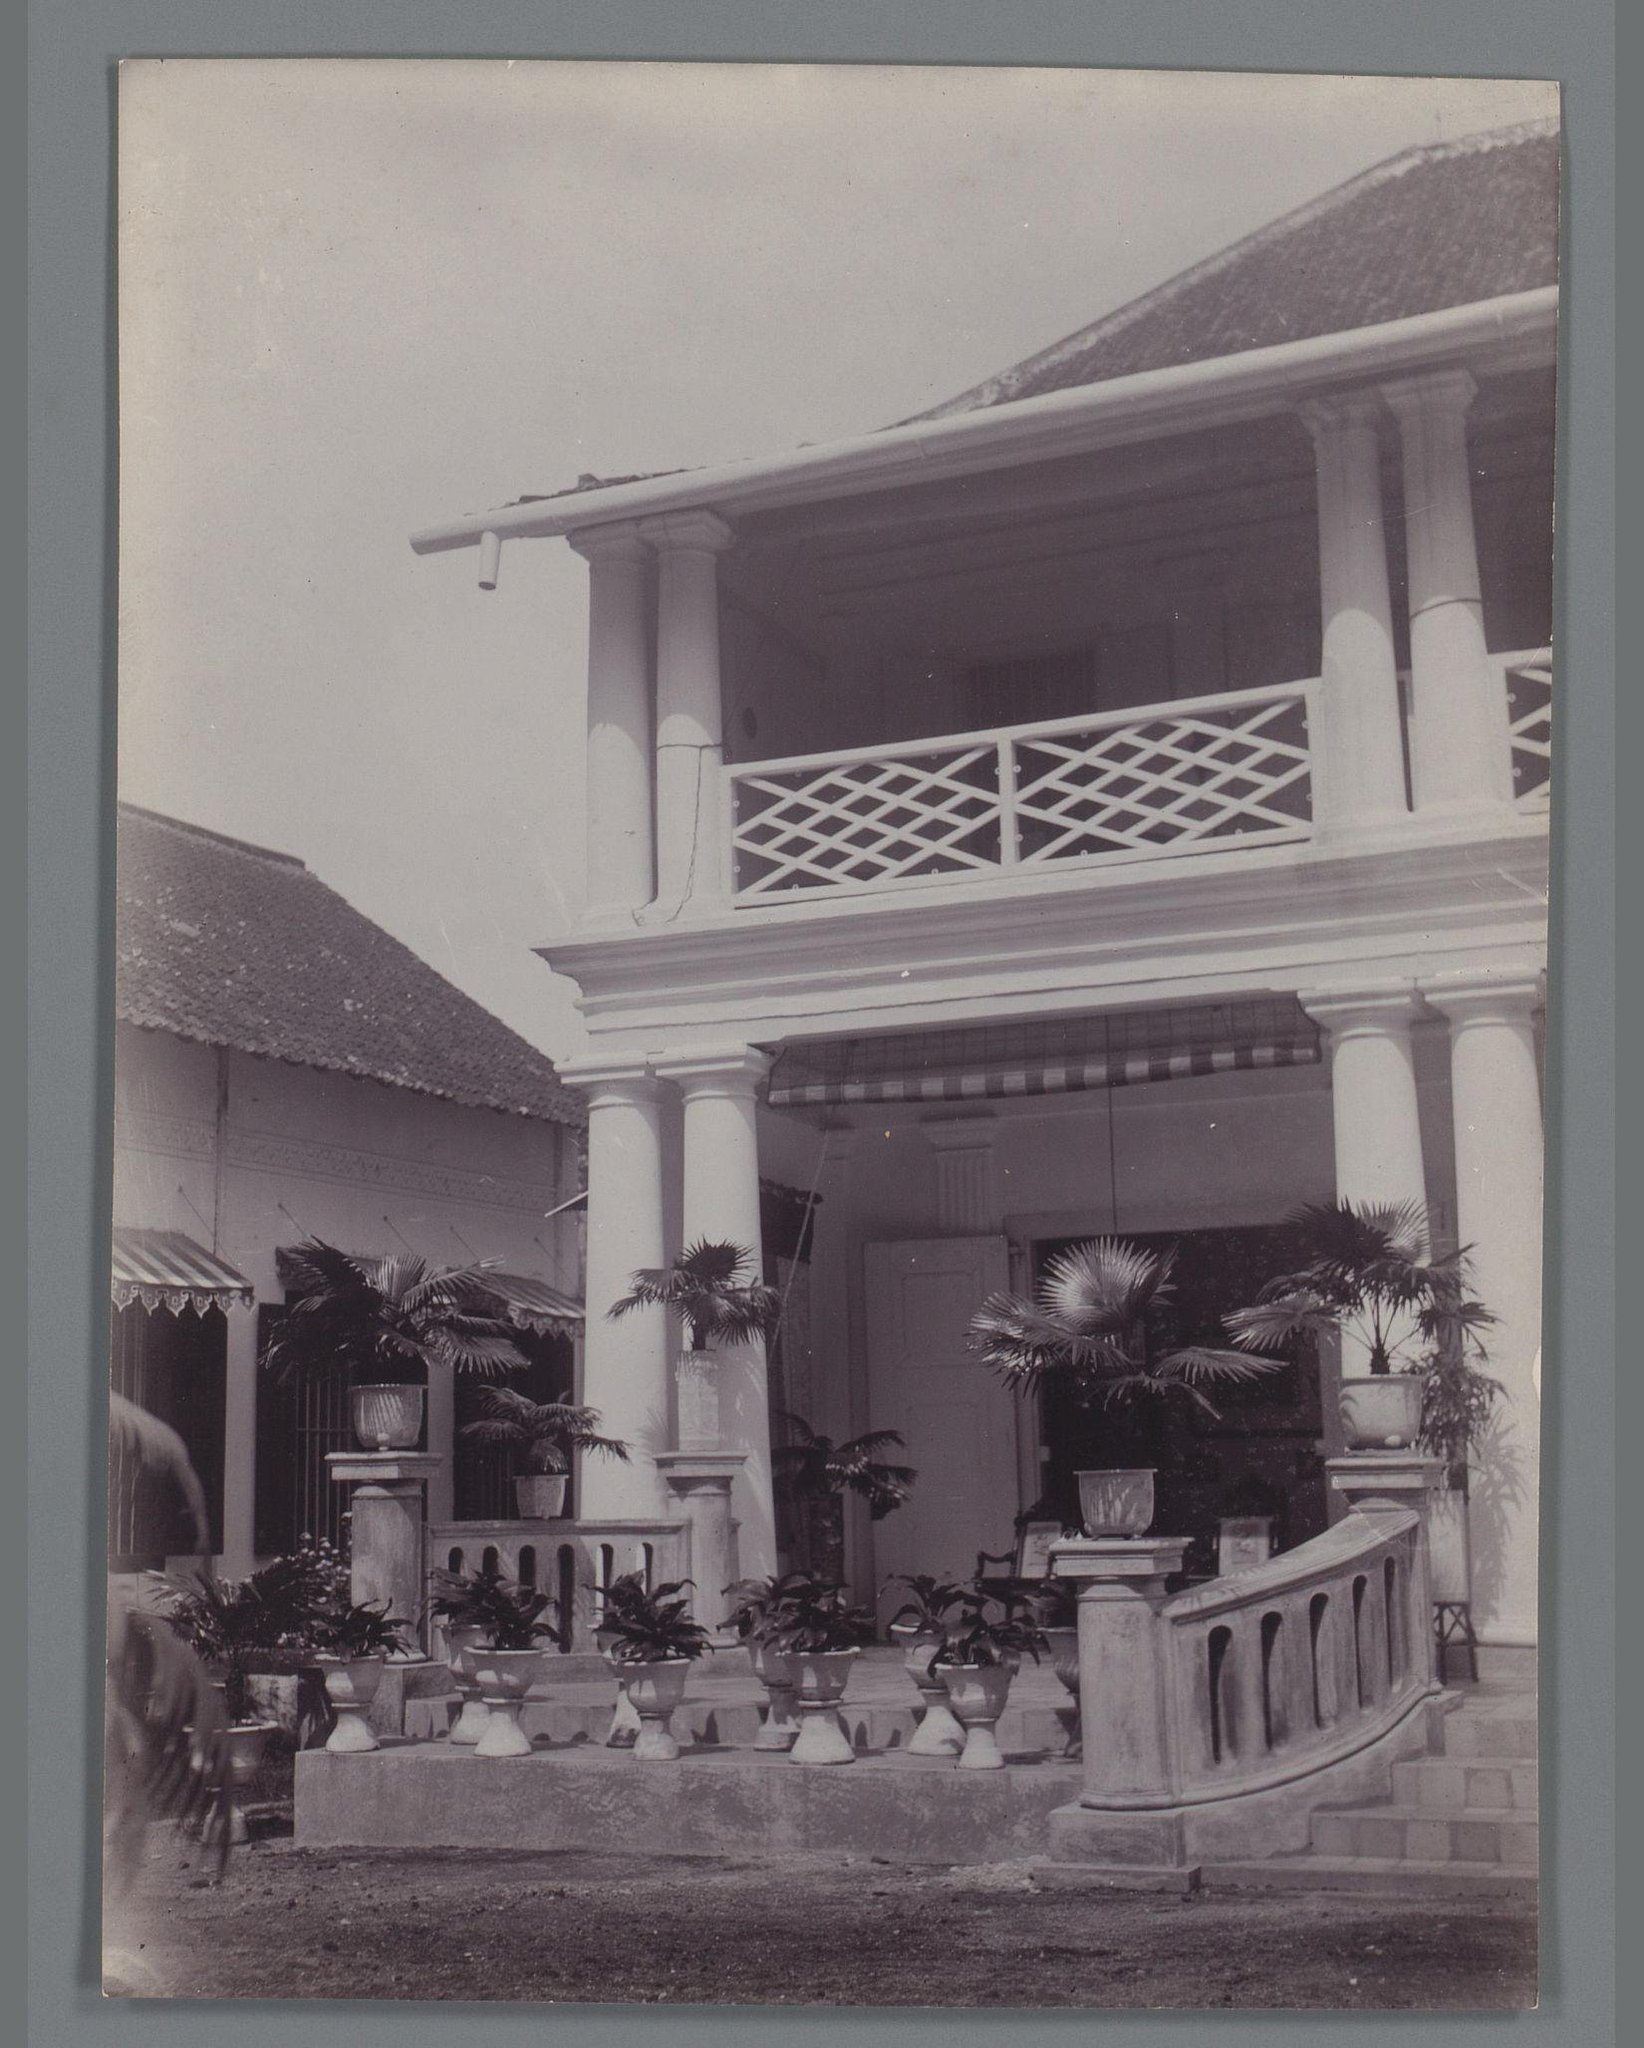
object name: photograph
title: Huis met veranda, Nederlands-Indië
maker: Anonymous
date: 1890-1920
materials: paper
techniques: matte daylight collodion silver print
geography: dutch east indies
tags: façade (of house or building), loggia, verandah, porch, dutch east indies, the